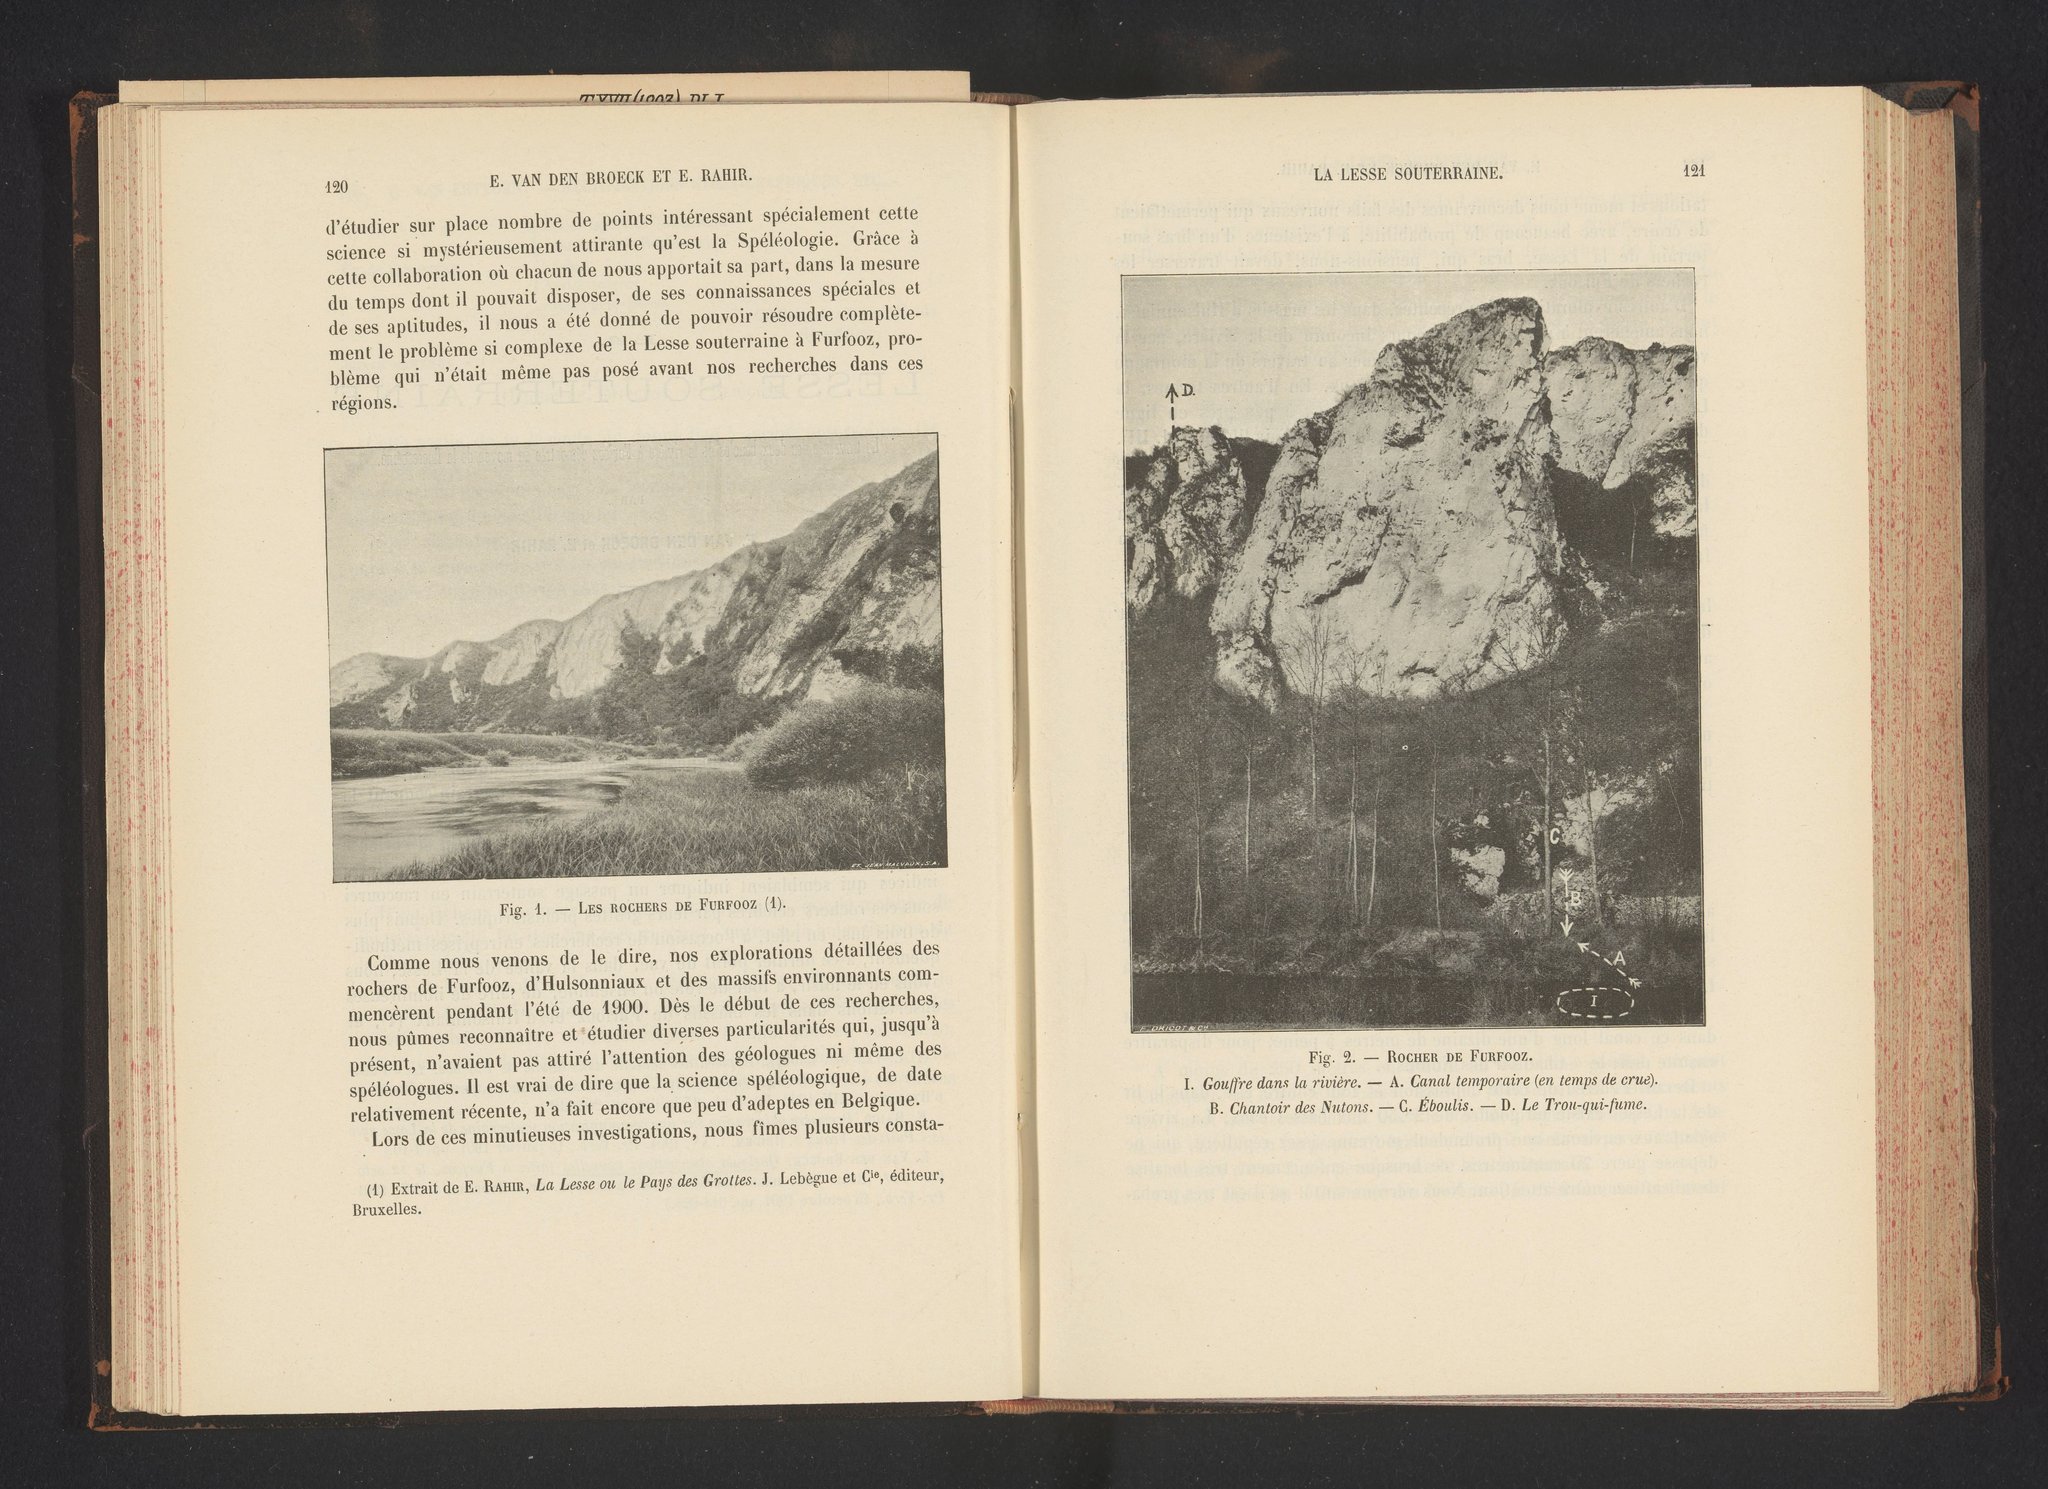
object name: photomechanical print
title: Rocher de Furfooz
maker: Anonymous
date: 1897-1903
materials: paper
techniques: autotype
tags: river, mountains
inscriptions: inscription: ‘I. Gouffre dans la rivière. - A. Canal temporaire (en temps de crue). B Chantoir des Nutons. - C. Éboulis. - D. Le Trou-qui-fume’